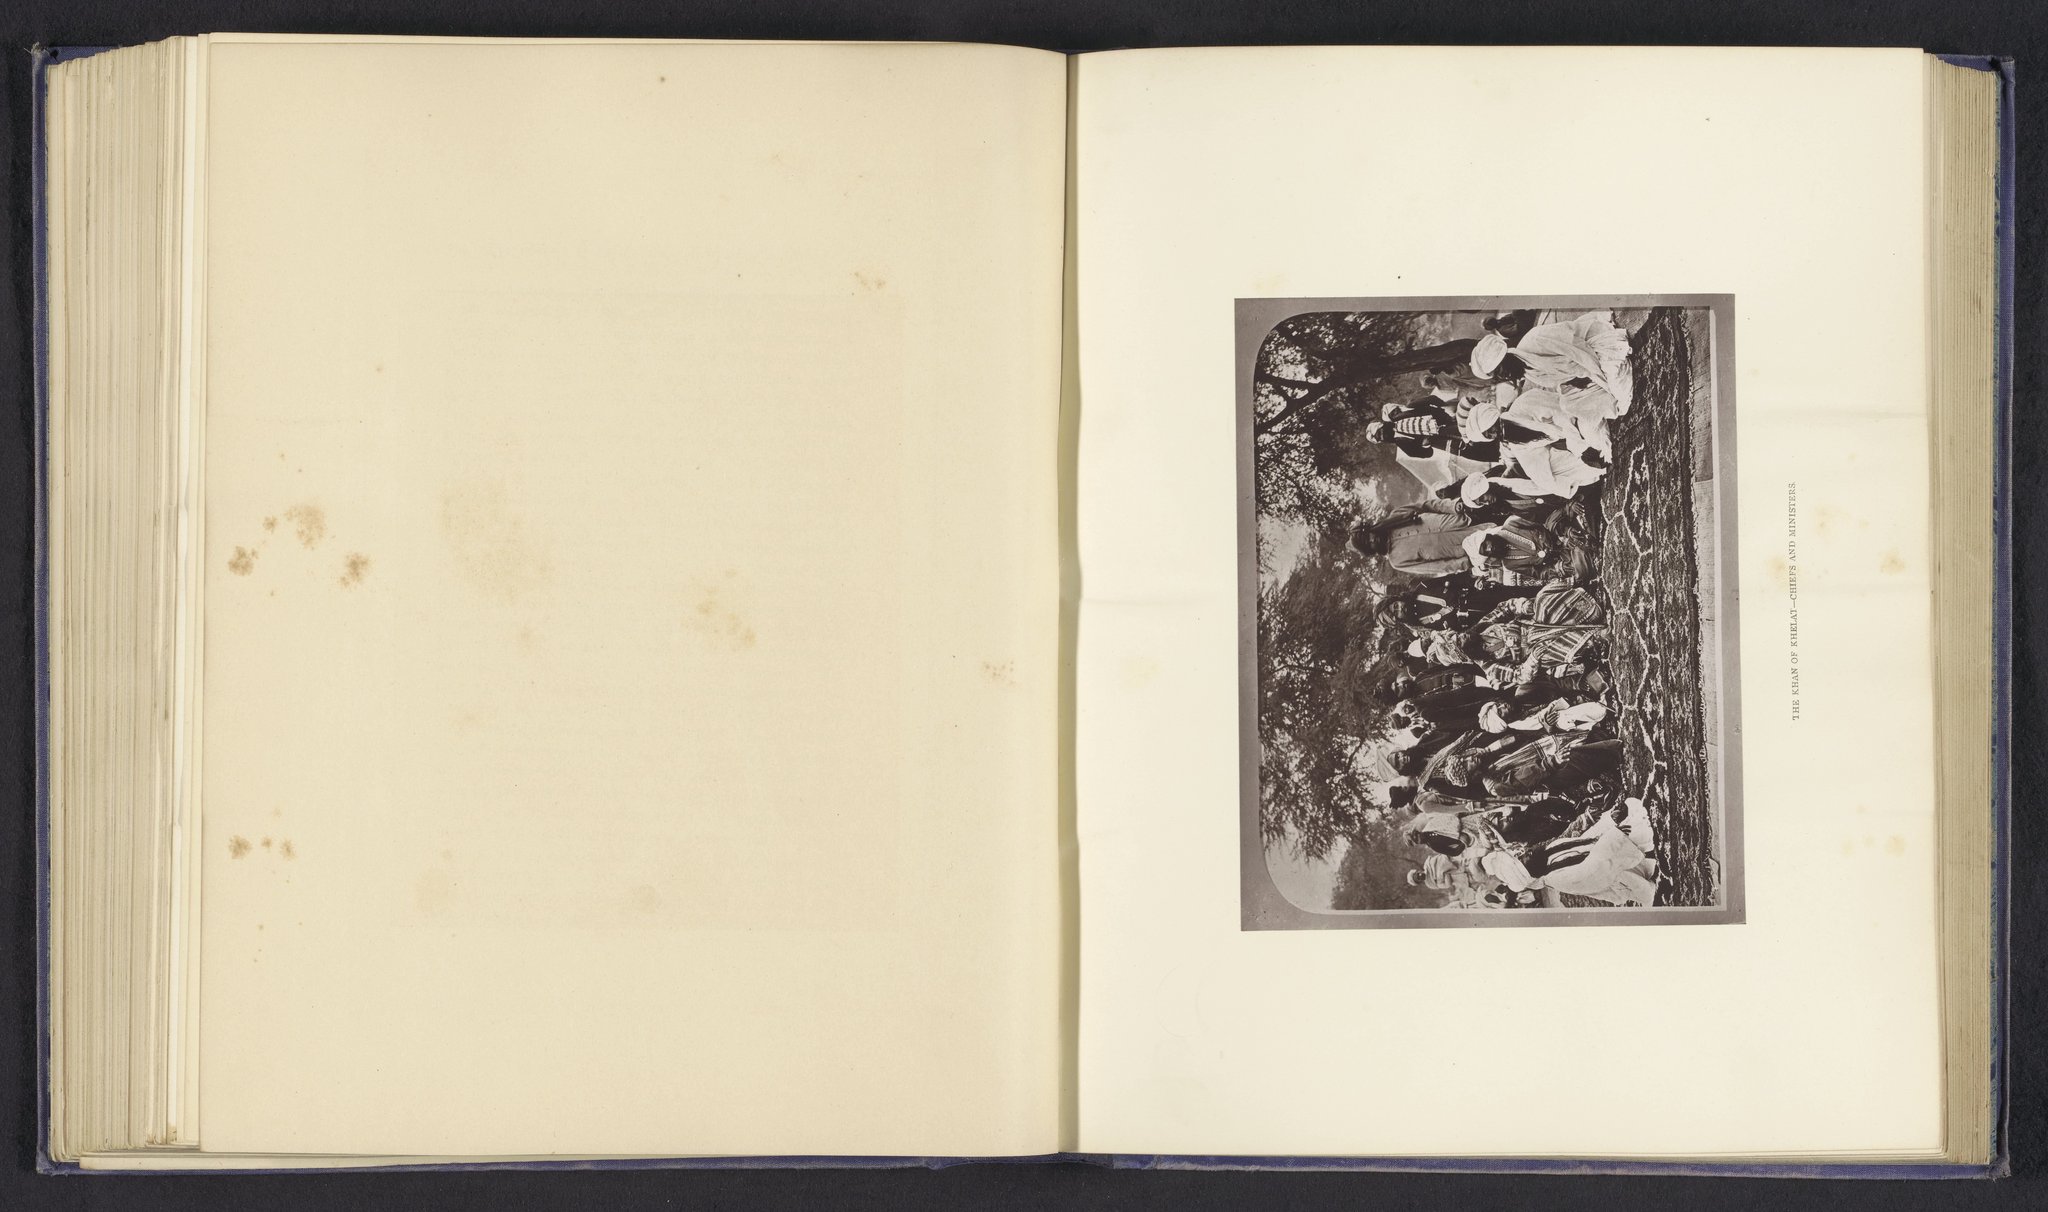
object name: page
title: The Khan of Khelat-chiefs and ministers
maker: Anonymous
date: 1876-1877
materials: paper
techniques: woodburytype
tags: ruler, sovereign